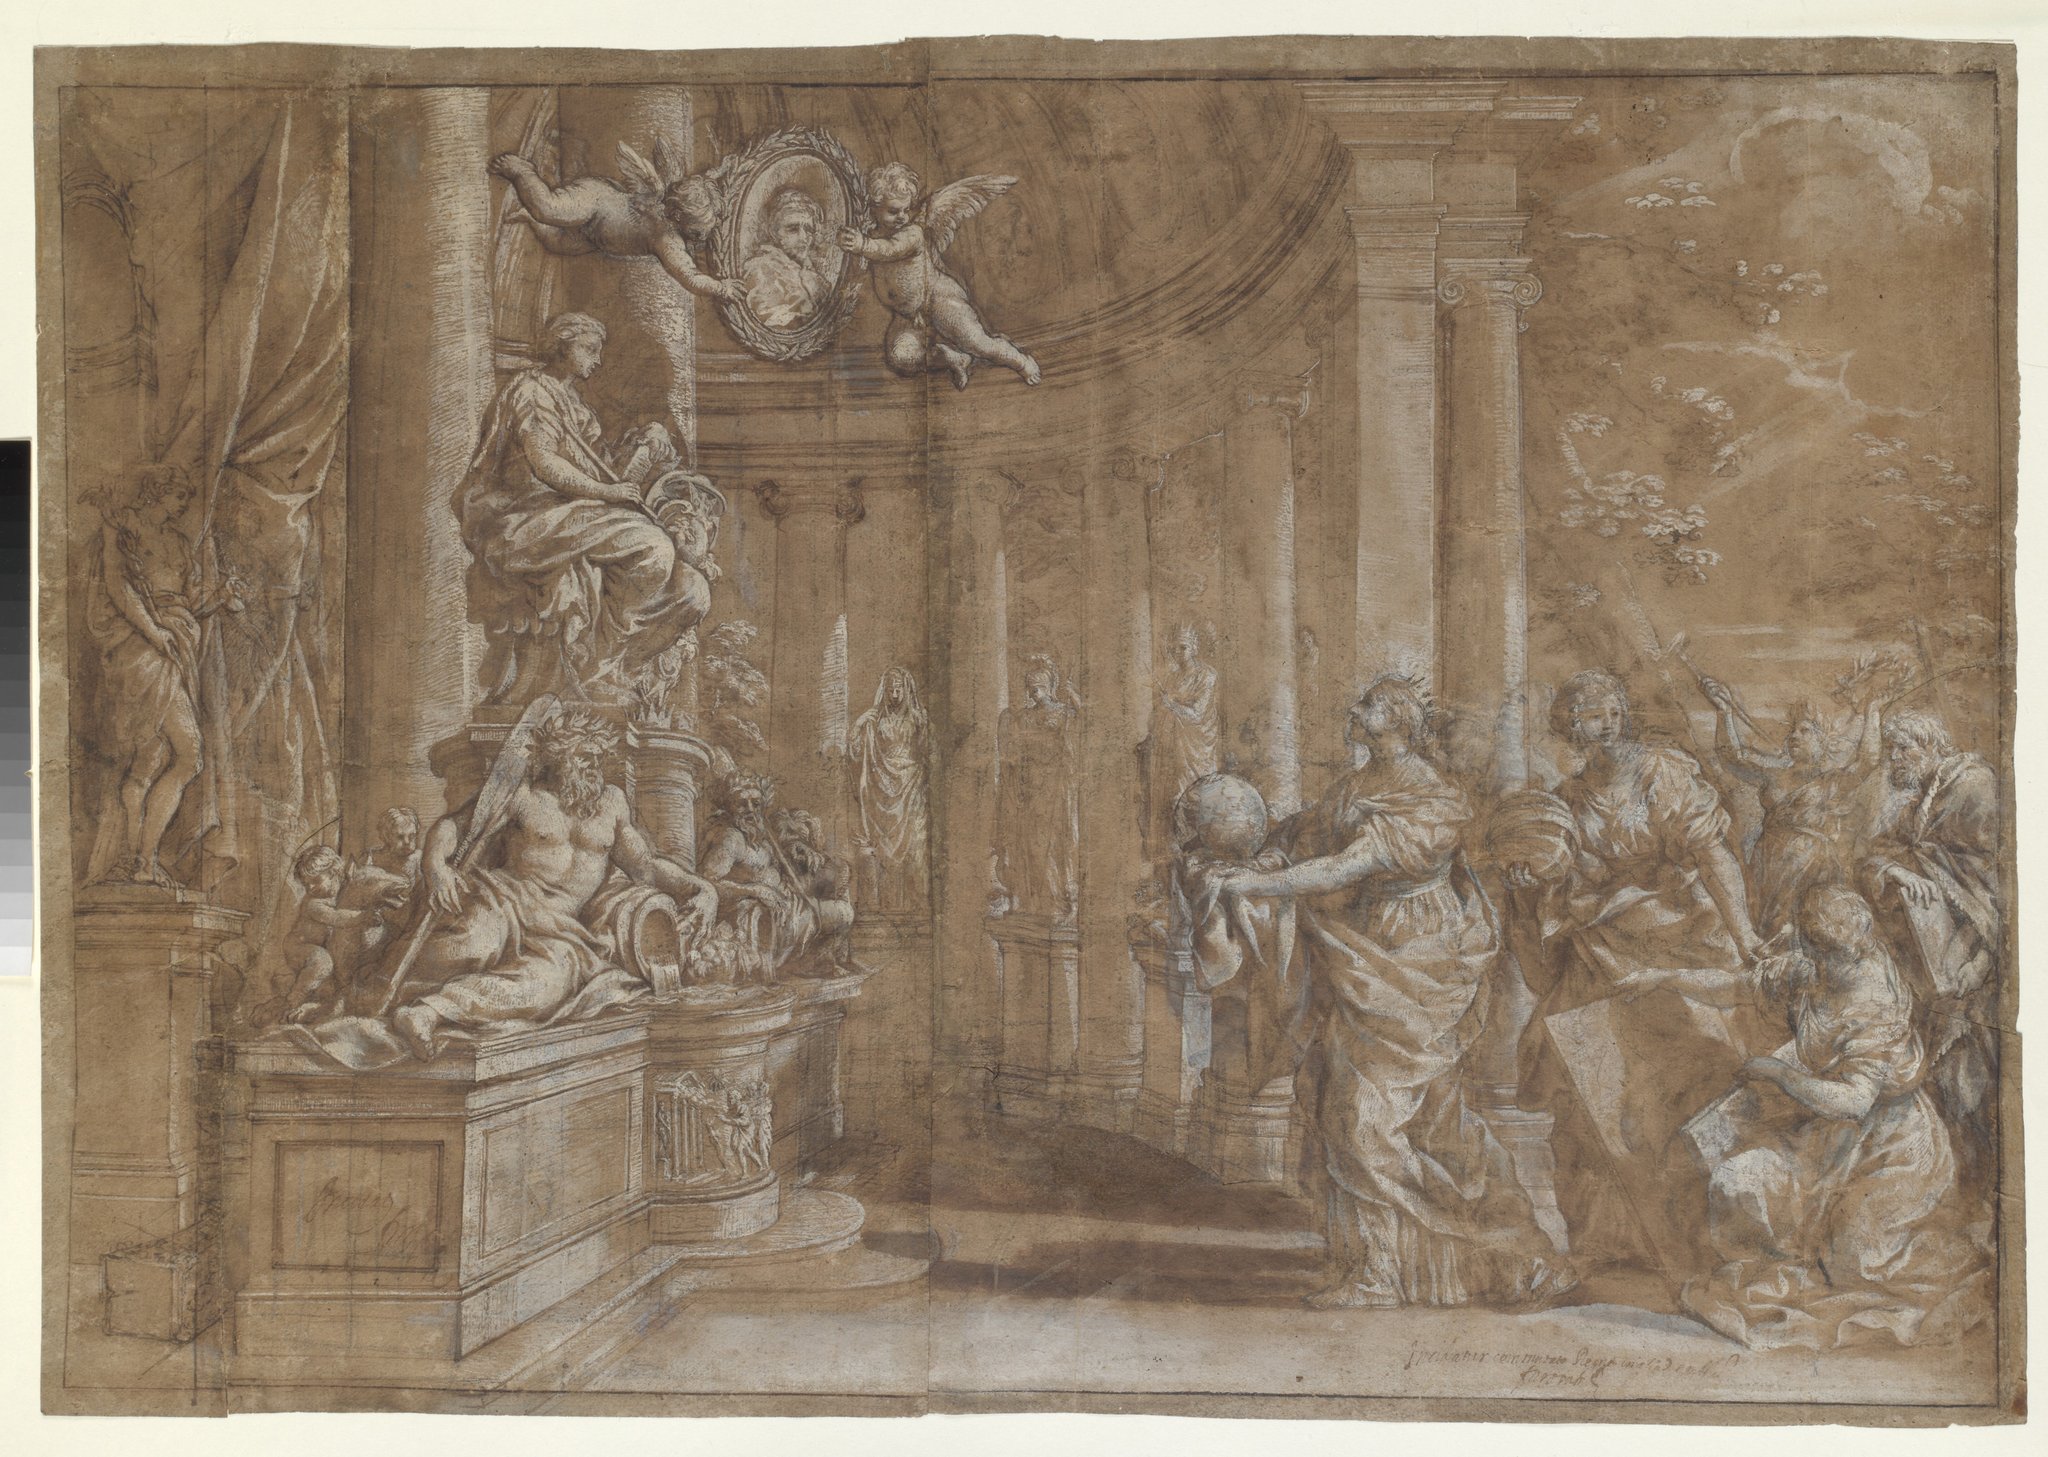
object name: drawing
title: Design for a Thesis Print with an Allegory of Knowledge and Portrait of Cardinal Antonio Barberini the Younger (1607–1671)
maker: pietro da cortona (pietro berrettini)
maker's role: artist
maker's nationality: italian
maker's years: 1596-1669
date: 1635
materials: chalk, ink, paper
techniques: brush, highlighting, pen, wash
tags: human figures,men,portraits